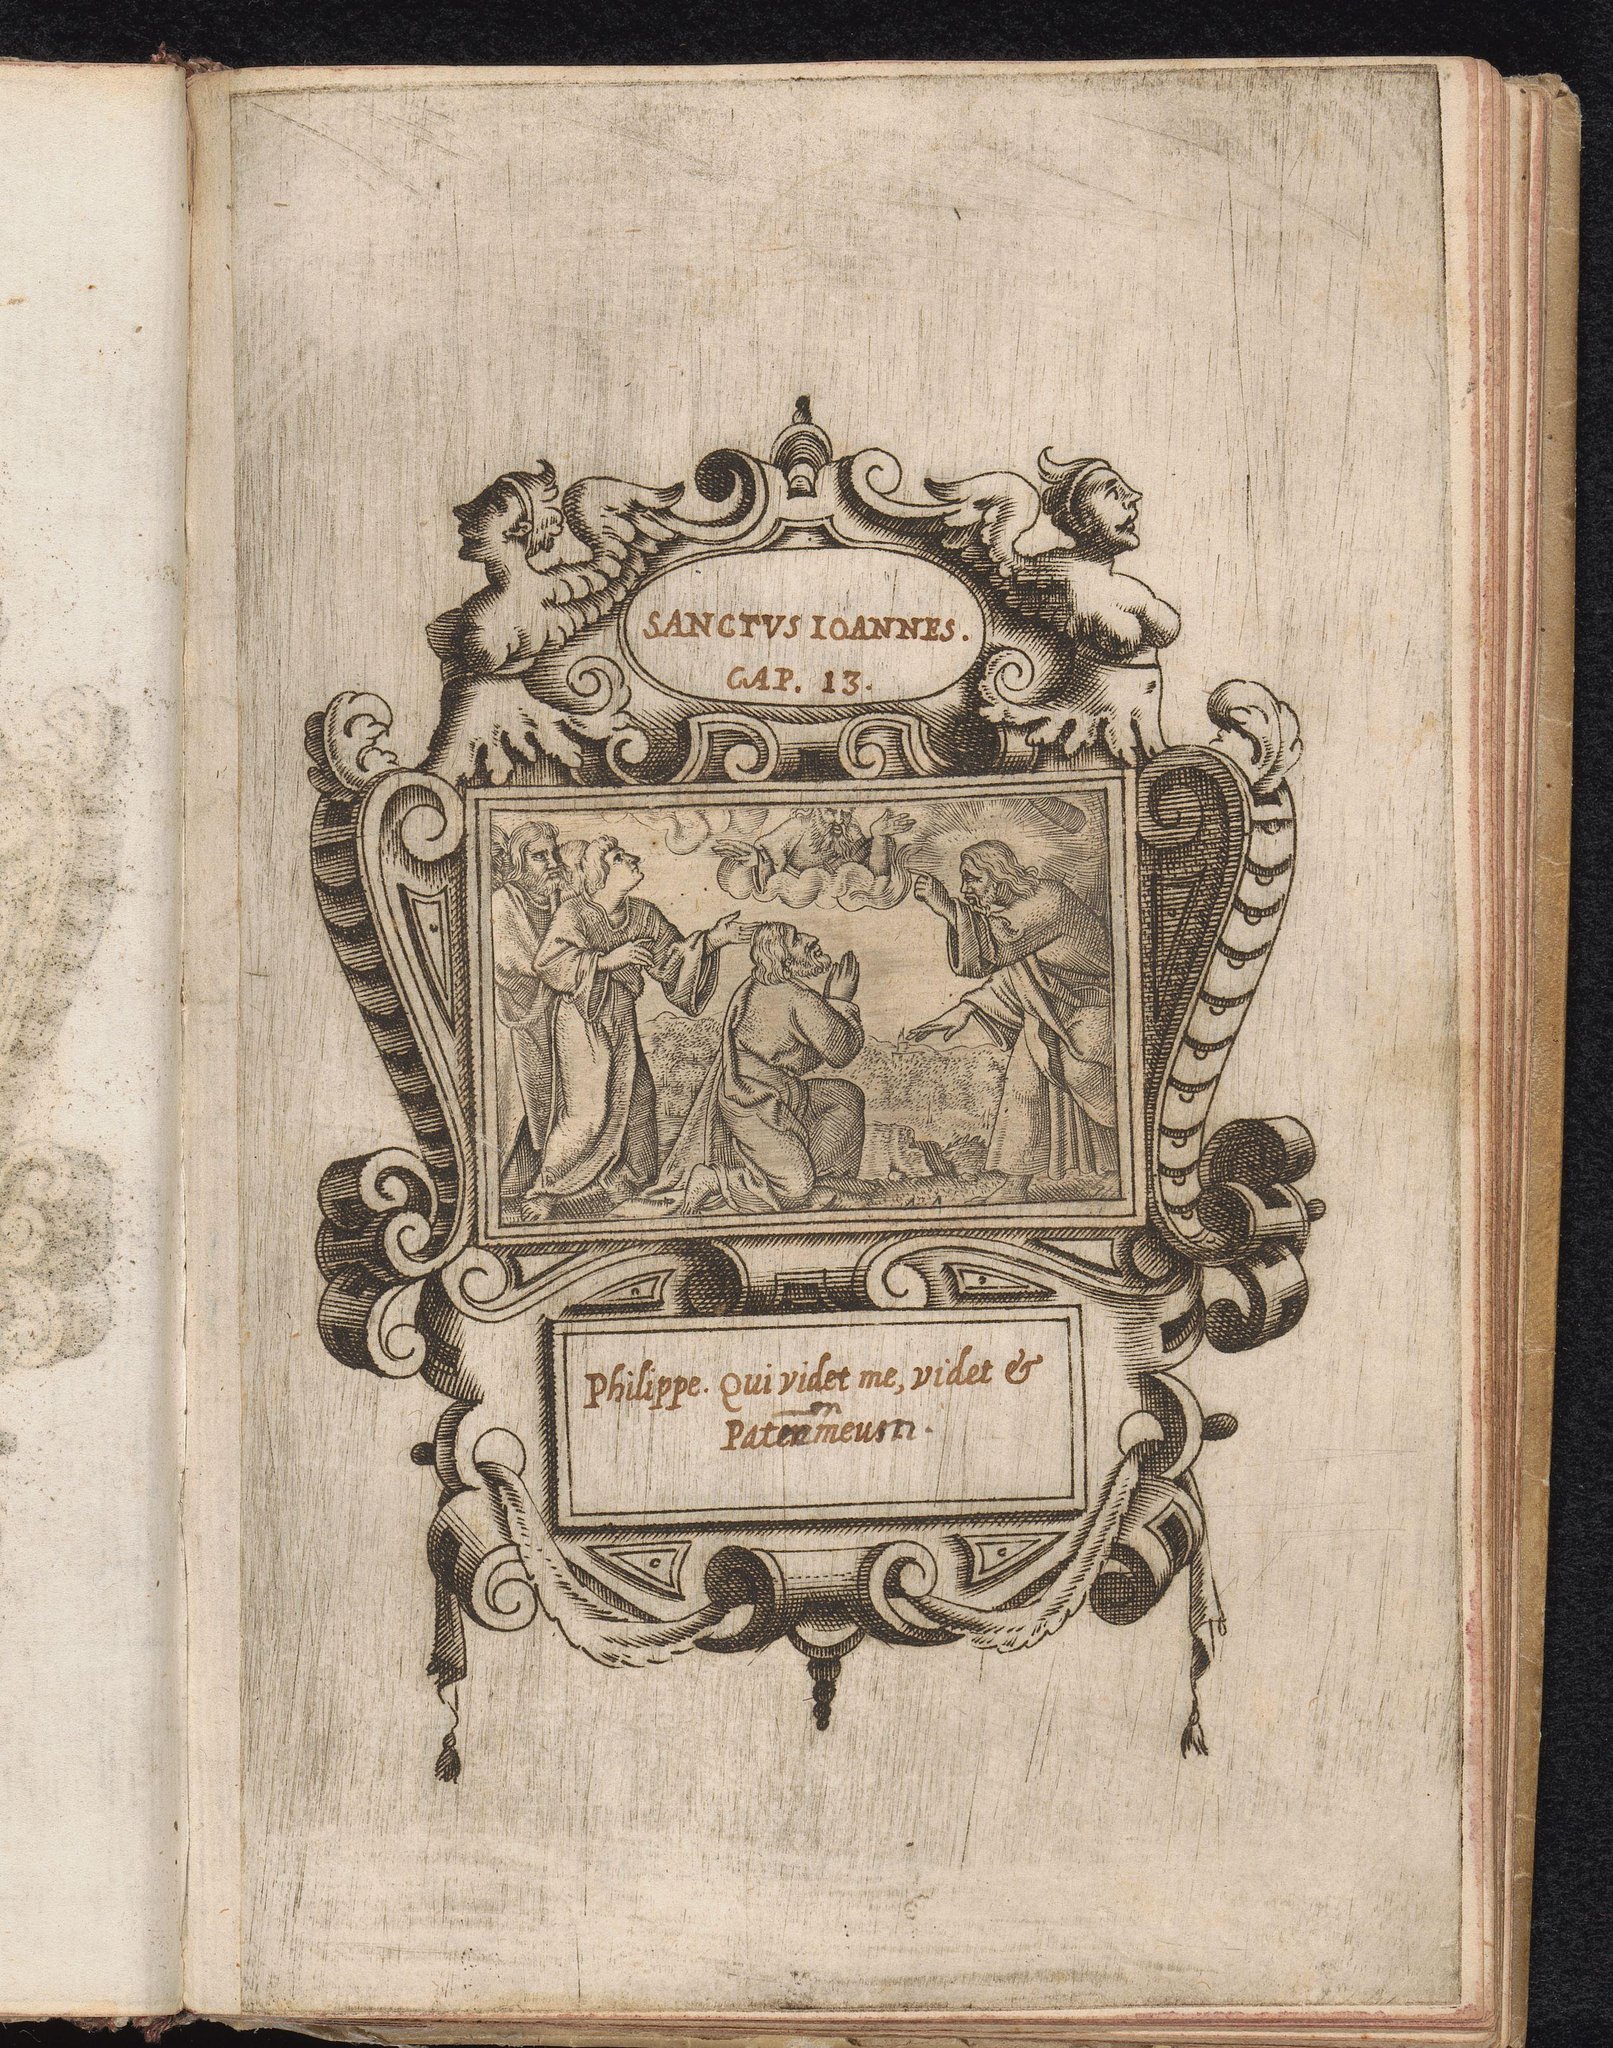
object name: print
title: Christus benoemt Petrus als hoofd van de kerk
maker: Anonymous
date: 1570-1610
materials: paper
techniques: engraving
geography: antwerp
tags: christ addressing his disciples after the last supper (john 14-16), christ asking the apostles: 'whom do men say that i am?' (matthew 16:13-23; mark 8:27-33; luke 9:18-22)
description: Christus benoemt Petrus als hoofd van de kerk. Onderdeel van een prentalbum met titelprent en 56 scènes uit het Nieuwe Testament. Elke voorstelling gemonteerd in een gravure met ornamentele cartouches waarin een venster is gesneden en voorzien van handgeschreven bijbelpassages.